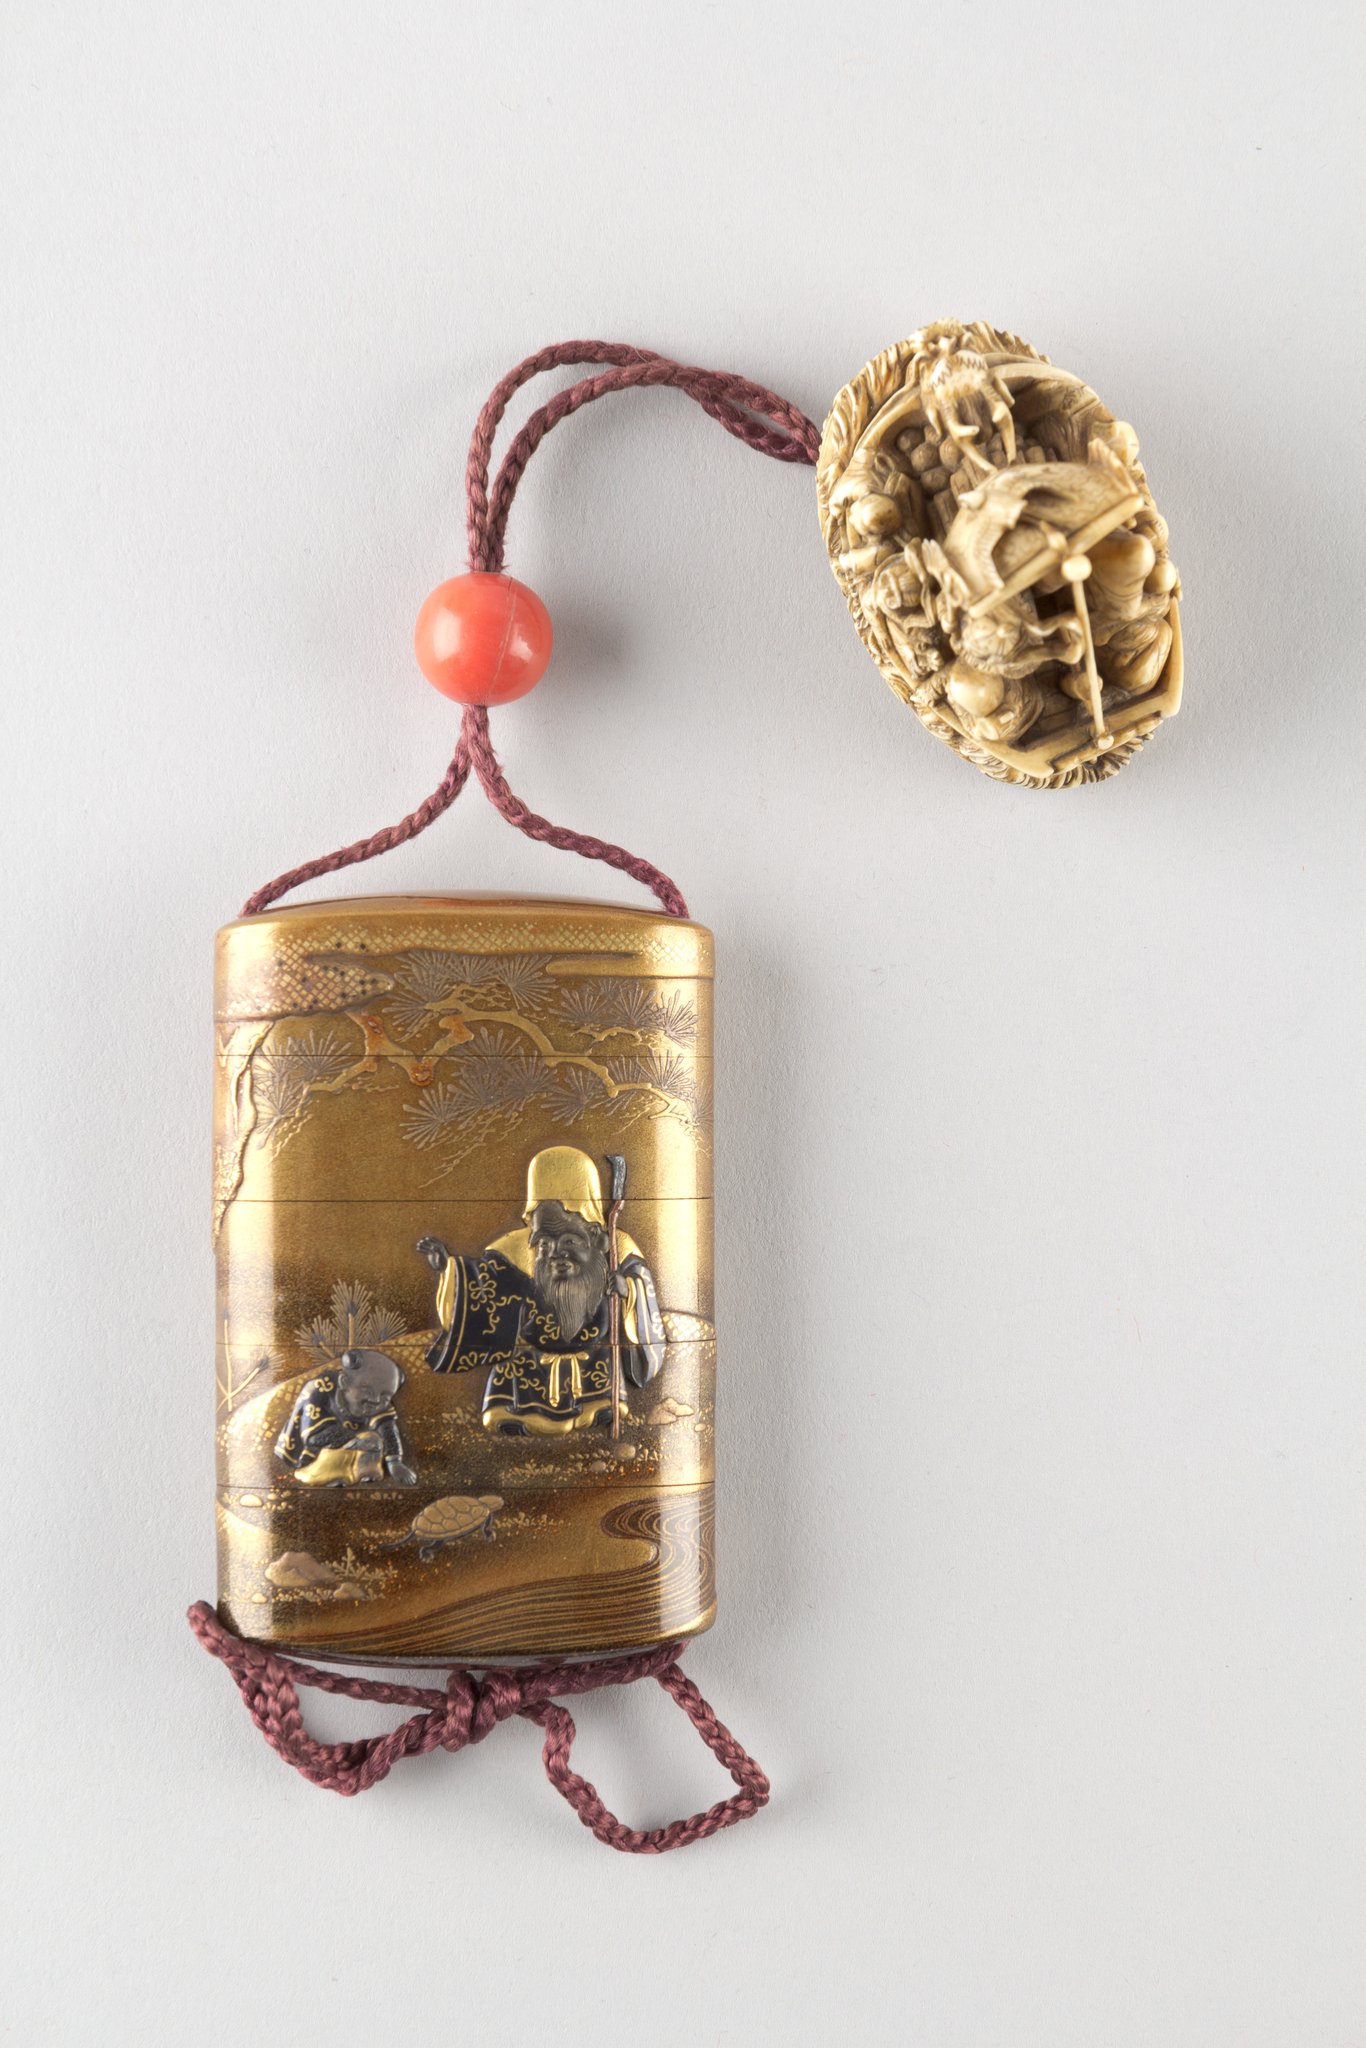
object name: inrō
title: Case (Inrō) with Design of God of Longevity (Jurōjin) and a Small Boy with a Tortoise (obverse); Pine Tree by Stream (reverse)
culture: japanese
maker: kakōsai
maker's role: artist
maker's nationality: japanese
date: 1801-1900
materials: coral, gold, lacquer, metal, silver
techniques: fundame, hiramakie, inlay, polish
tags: animals,boys,turtles